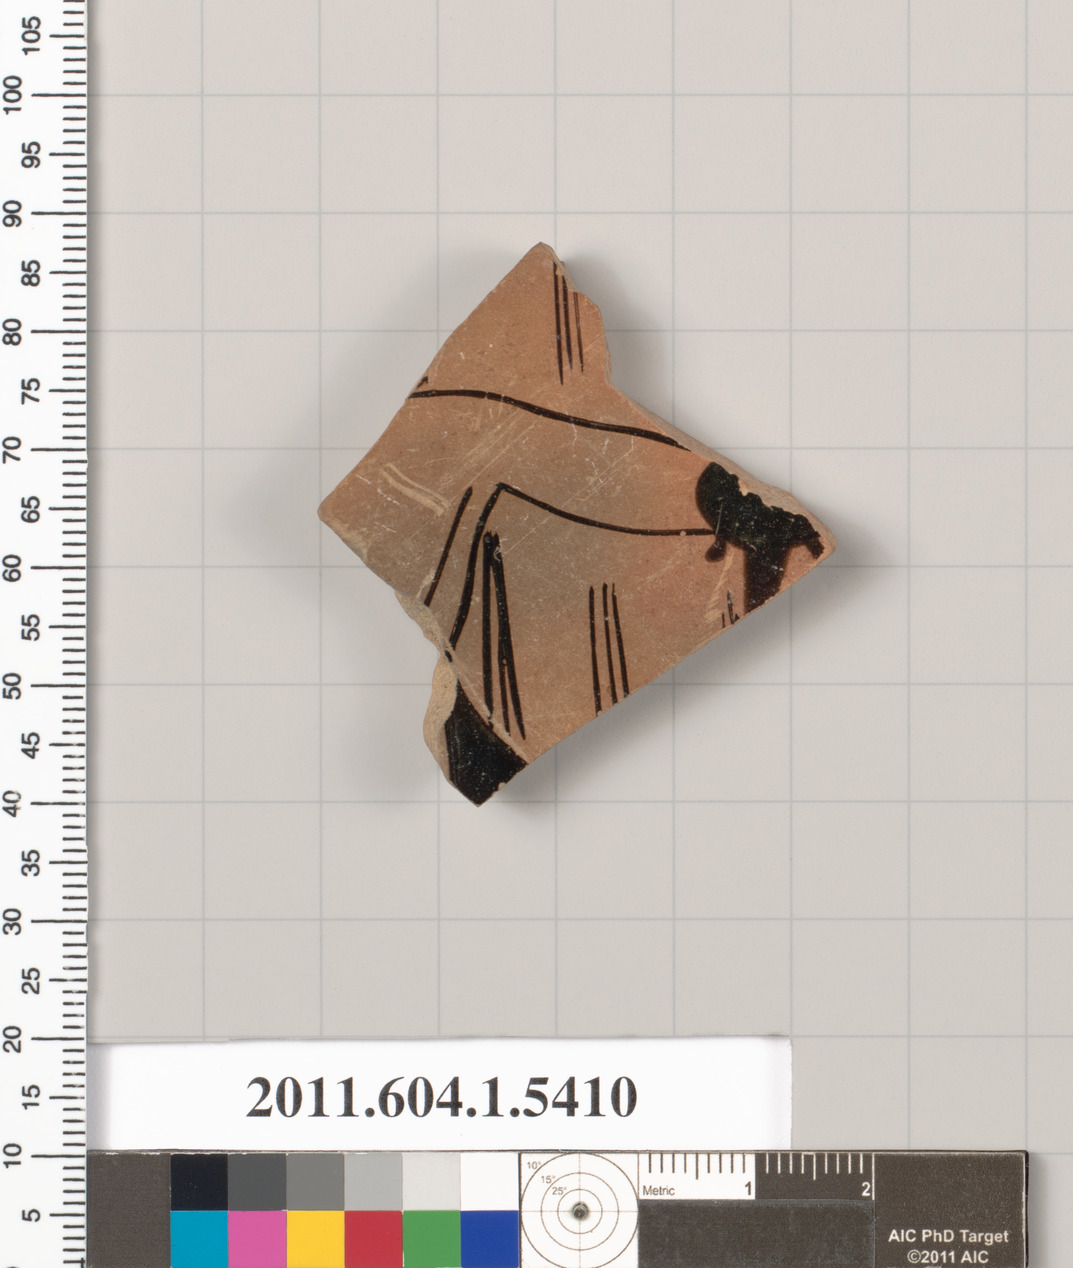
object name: kylix fragment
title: Terracotta fragment of a kylix (drinking cup)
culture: greek, attic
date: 500-480 BCE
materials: terracotta